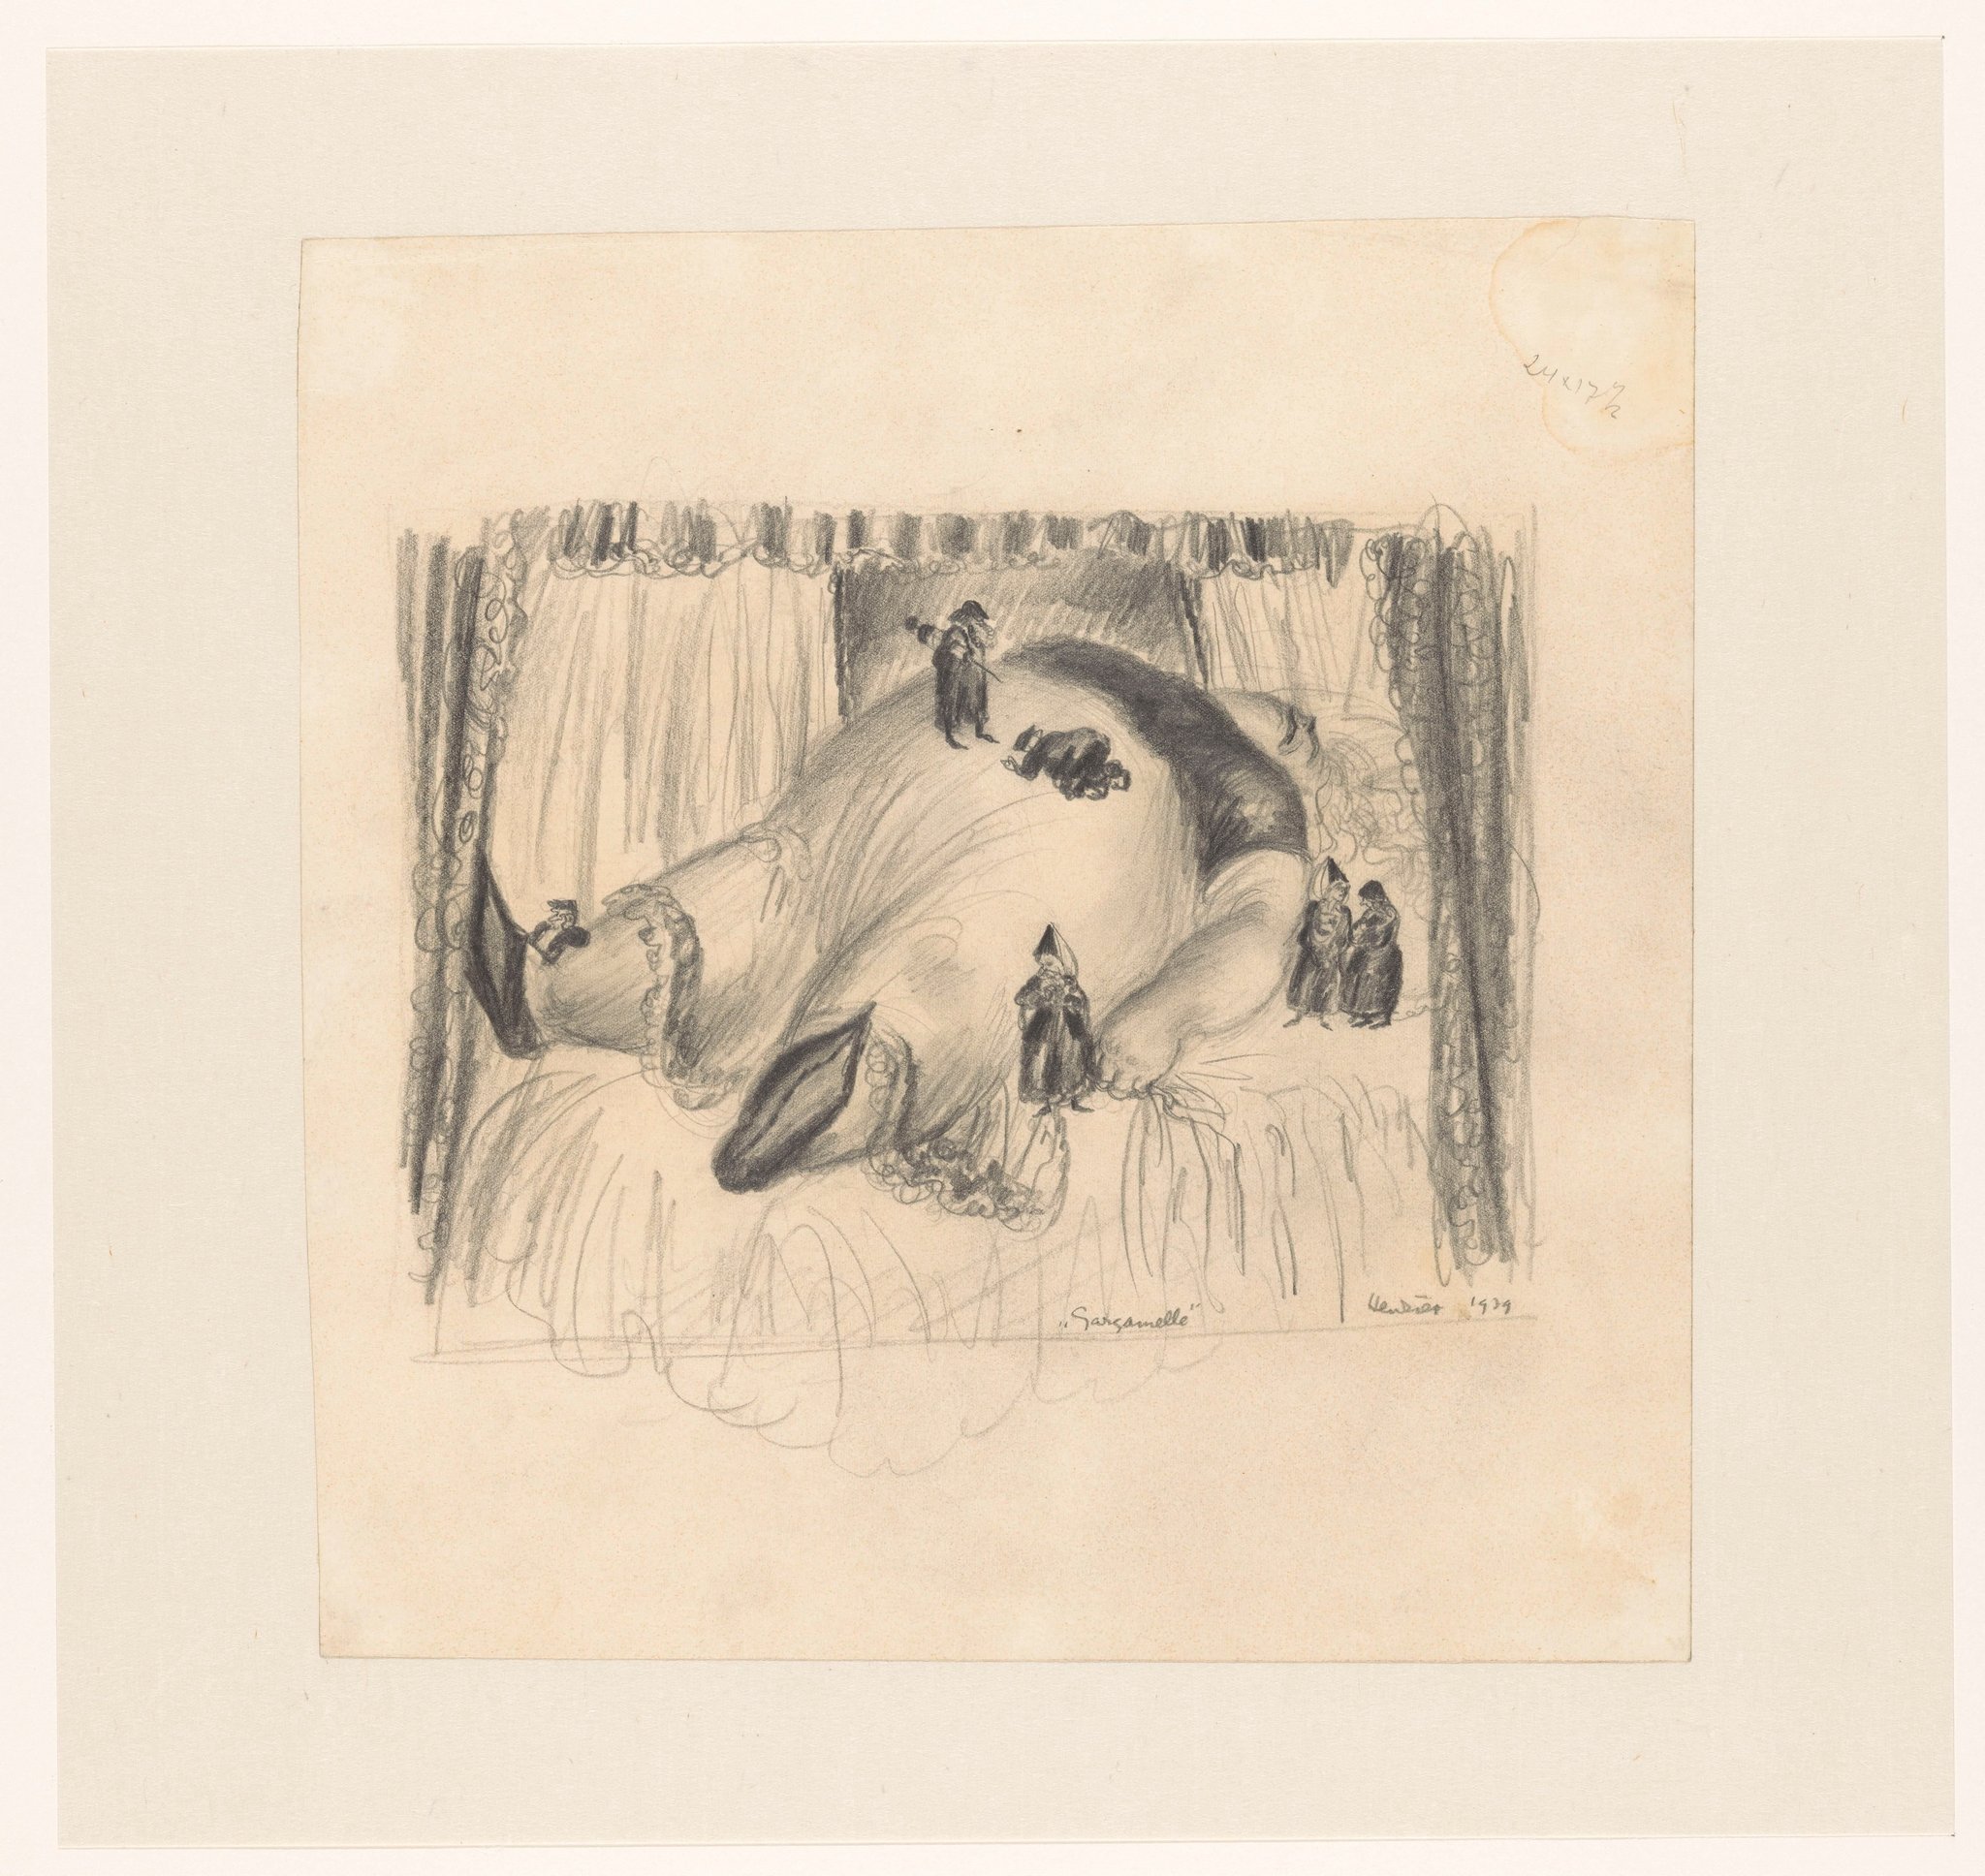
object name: drawing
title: Gargamelle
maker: henk henriët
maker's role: draughtsman, print maker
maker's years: 1903-1945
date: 1939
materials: paper, pencil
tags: bed, lying figure - aa - female human figure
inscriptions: collector's mark: Lugt 2228, inscription: ‘Mr. B. Kist, Koninginneweg 65/ Henriët, Rabelais’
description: Deze tekening is mogelijk een ontwerp voor een illustratie bij het boek 'Gargantua en Pantagruel' van François Rabelais.